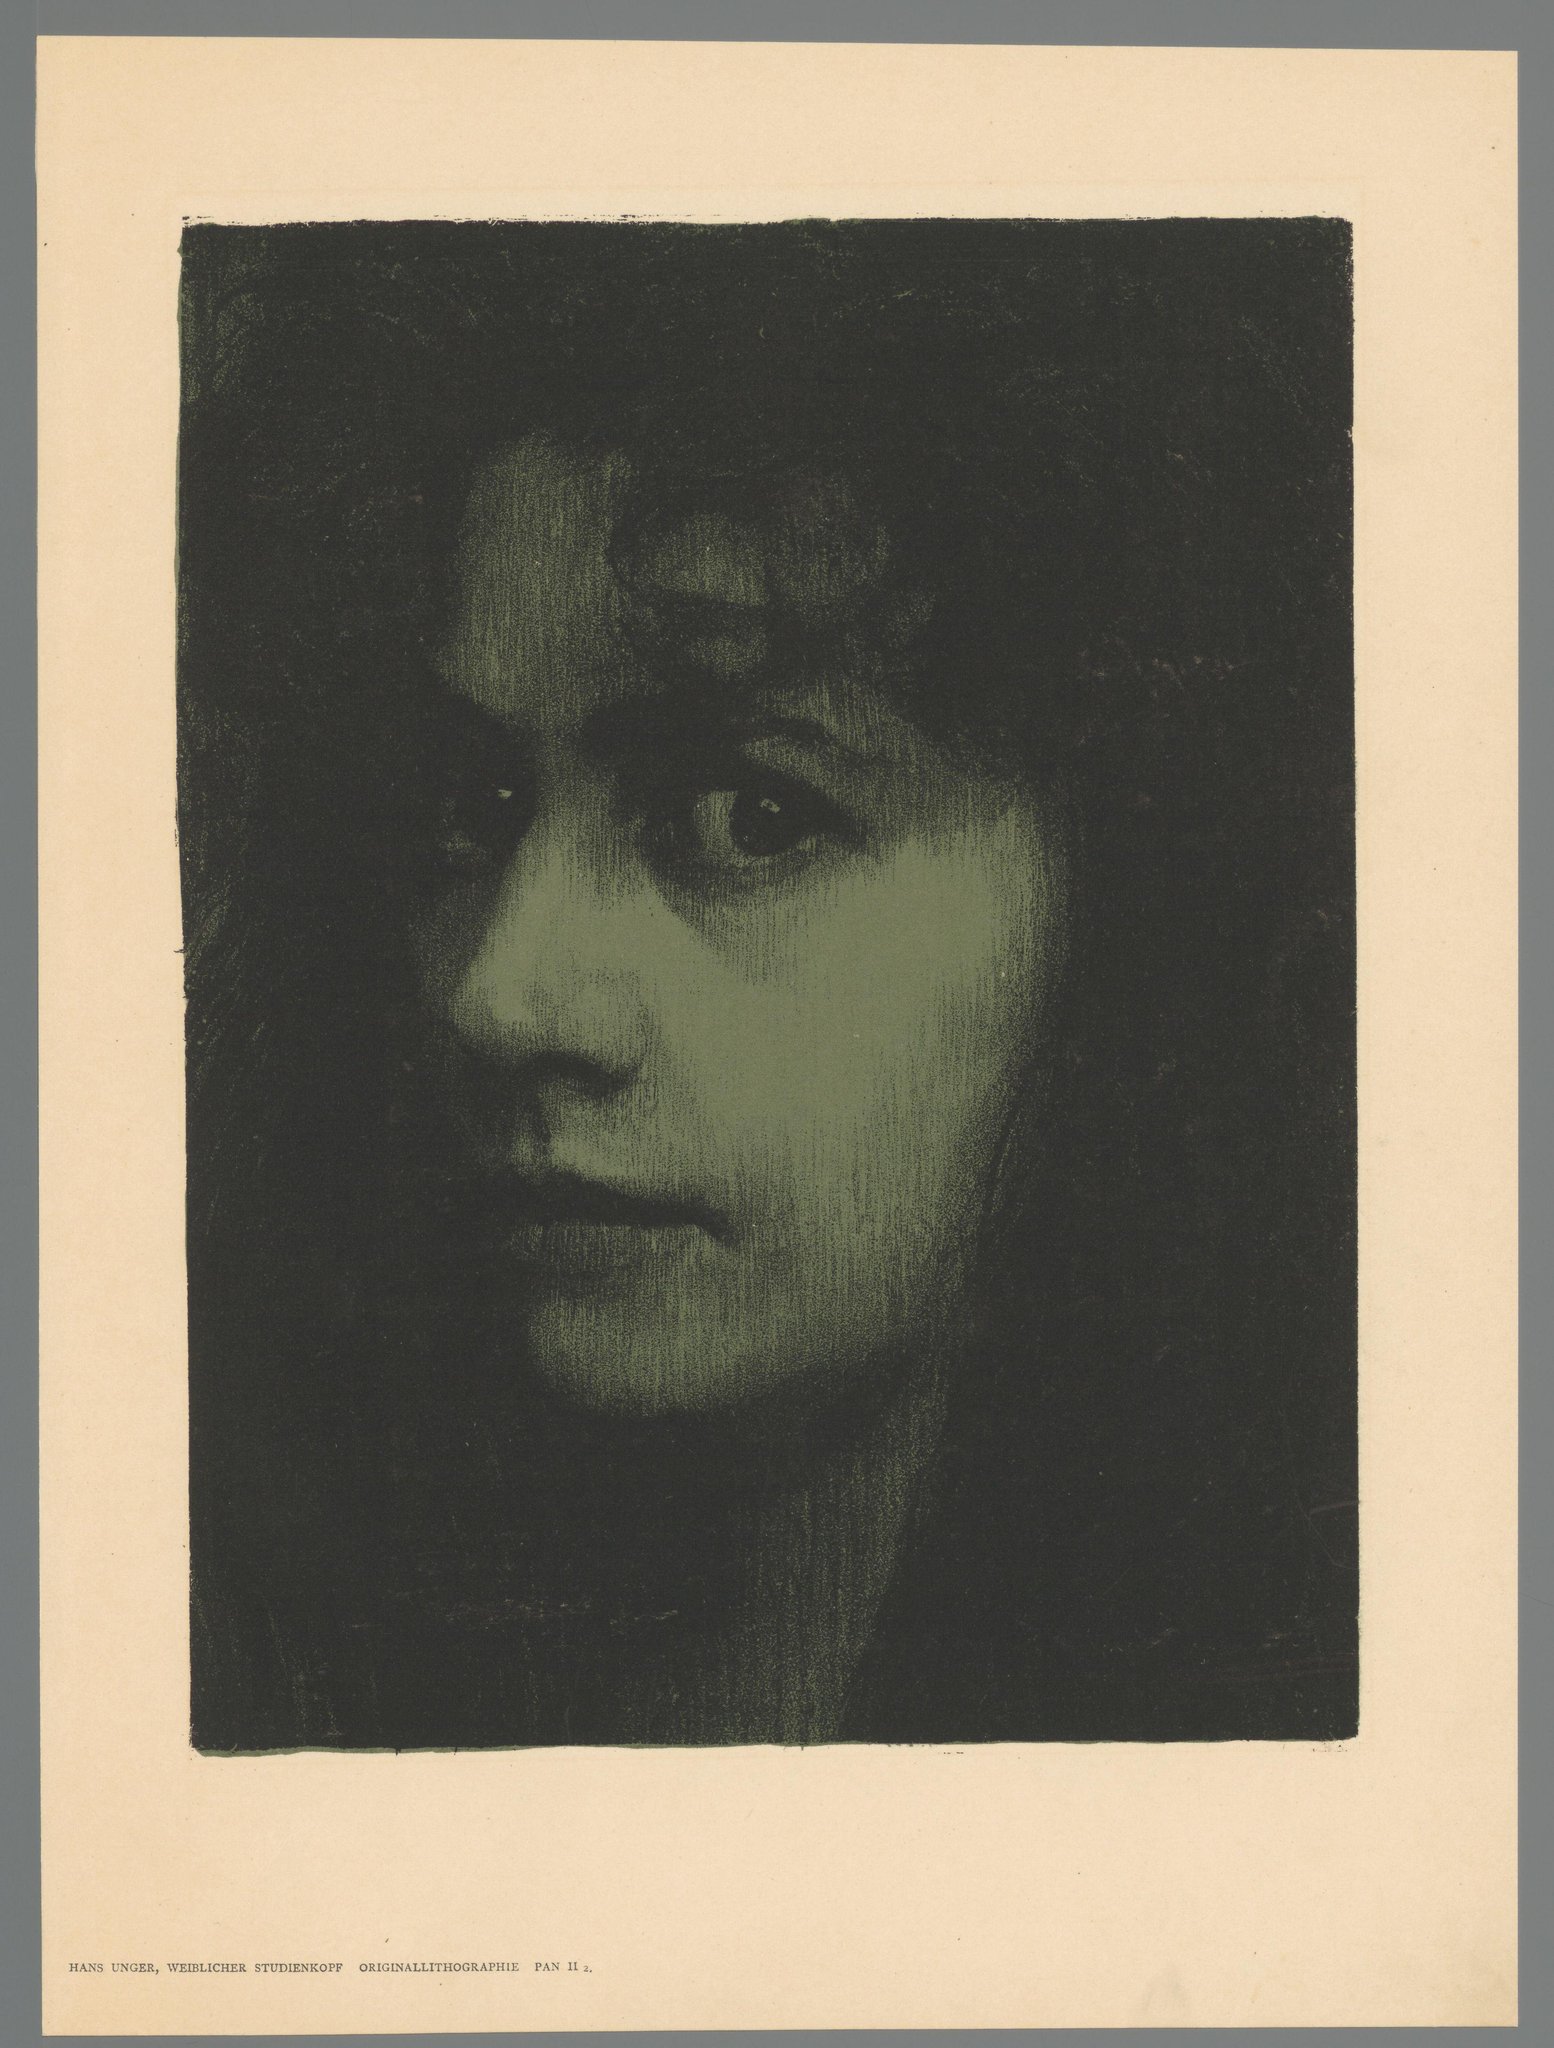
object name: print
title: Hoofd van een vrouw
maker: hans unger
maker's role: print maker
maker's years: 1872-1936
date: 1896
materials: paper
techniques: tone lithography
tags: adult woman